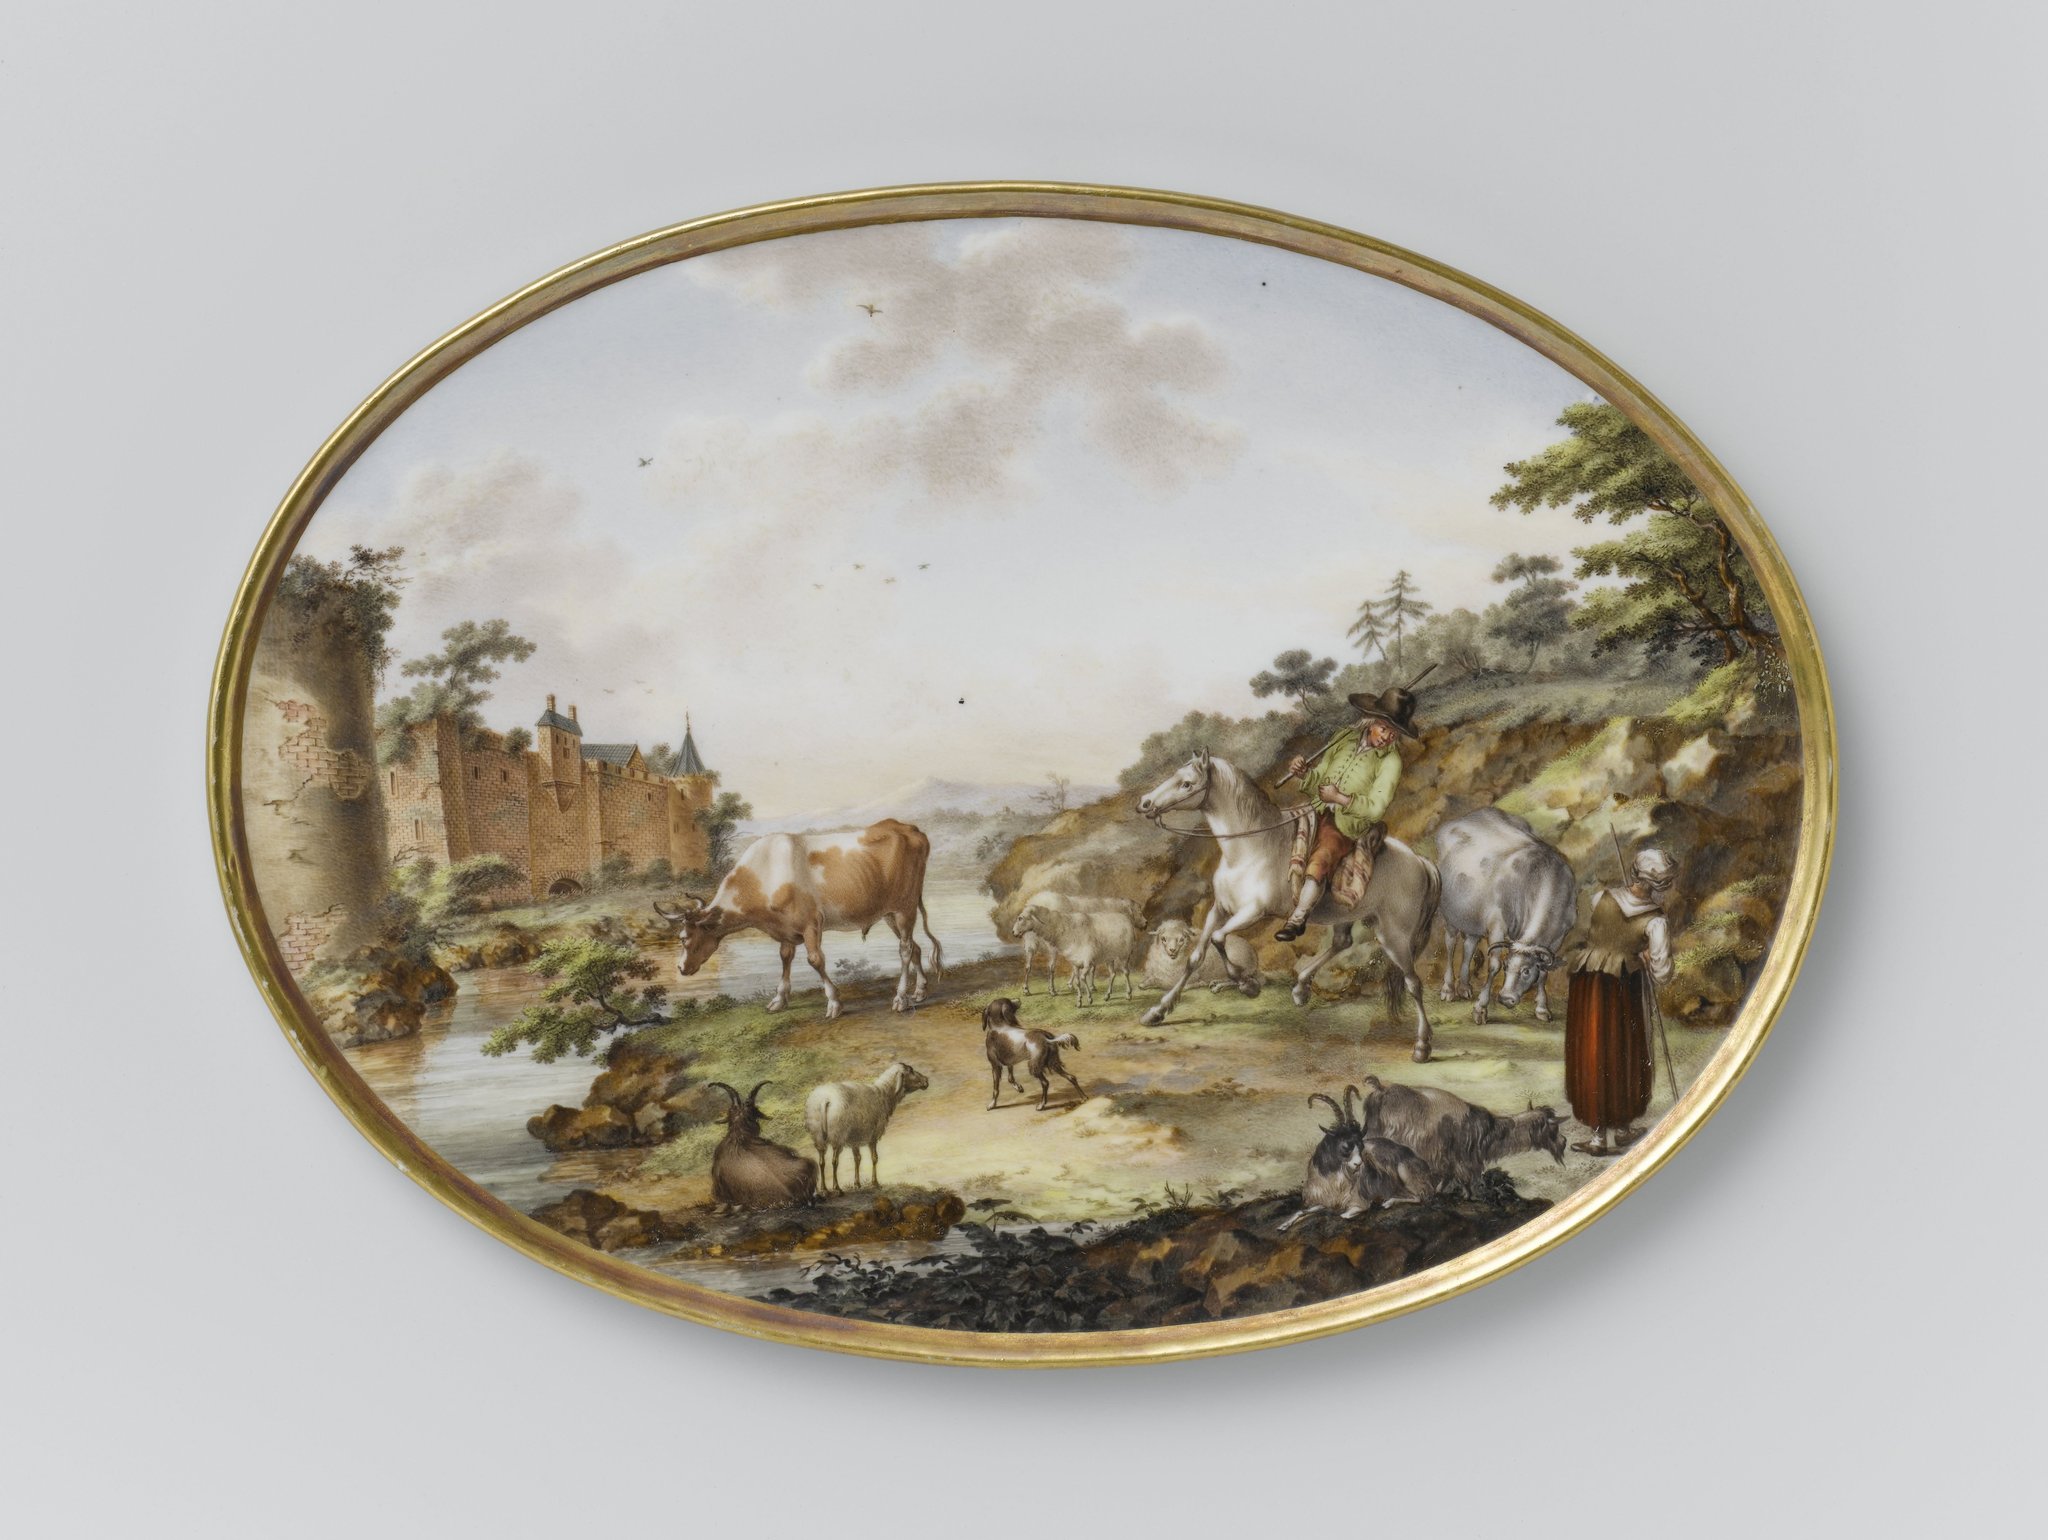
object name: plate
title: Two oval plates with figures and cattle in a river landscape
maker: joseph balthasar zwinger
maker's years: -1795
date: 1778-1782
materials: porcelain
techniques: painted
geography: loosdrecht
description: Manufactuur Oud-Loosdrecht painted decoration: attributed to Joseph Balthasar Zwinger (?–1795) after a print by Abraham Rademaker (1676–1735) Loosdrecht, c. 1778–1782 hard-paste porcelain